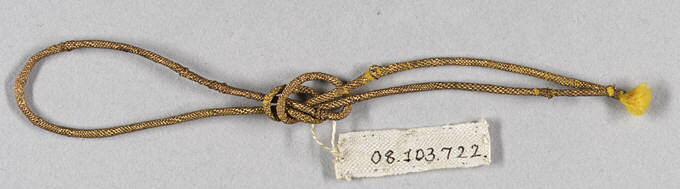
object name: thread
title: Tinsel and metal thread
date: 1601-1800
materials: metal thread